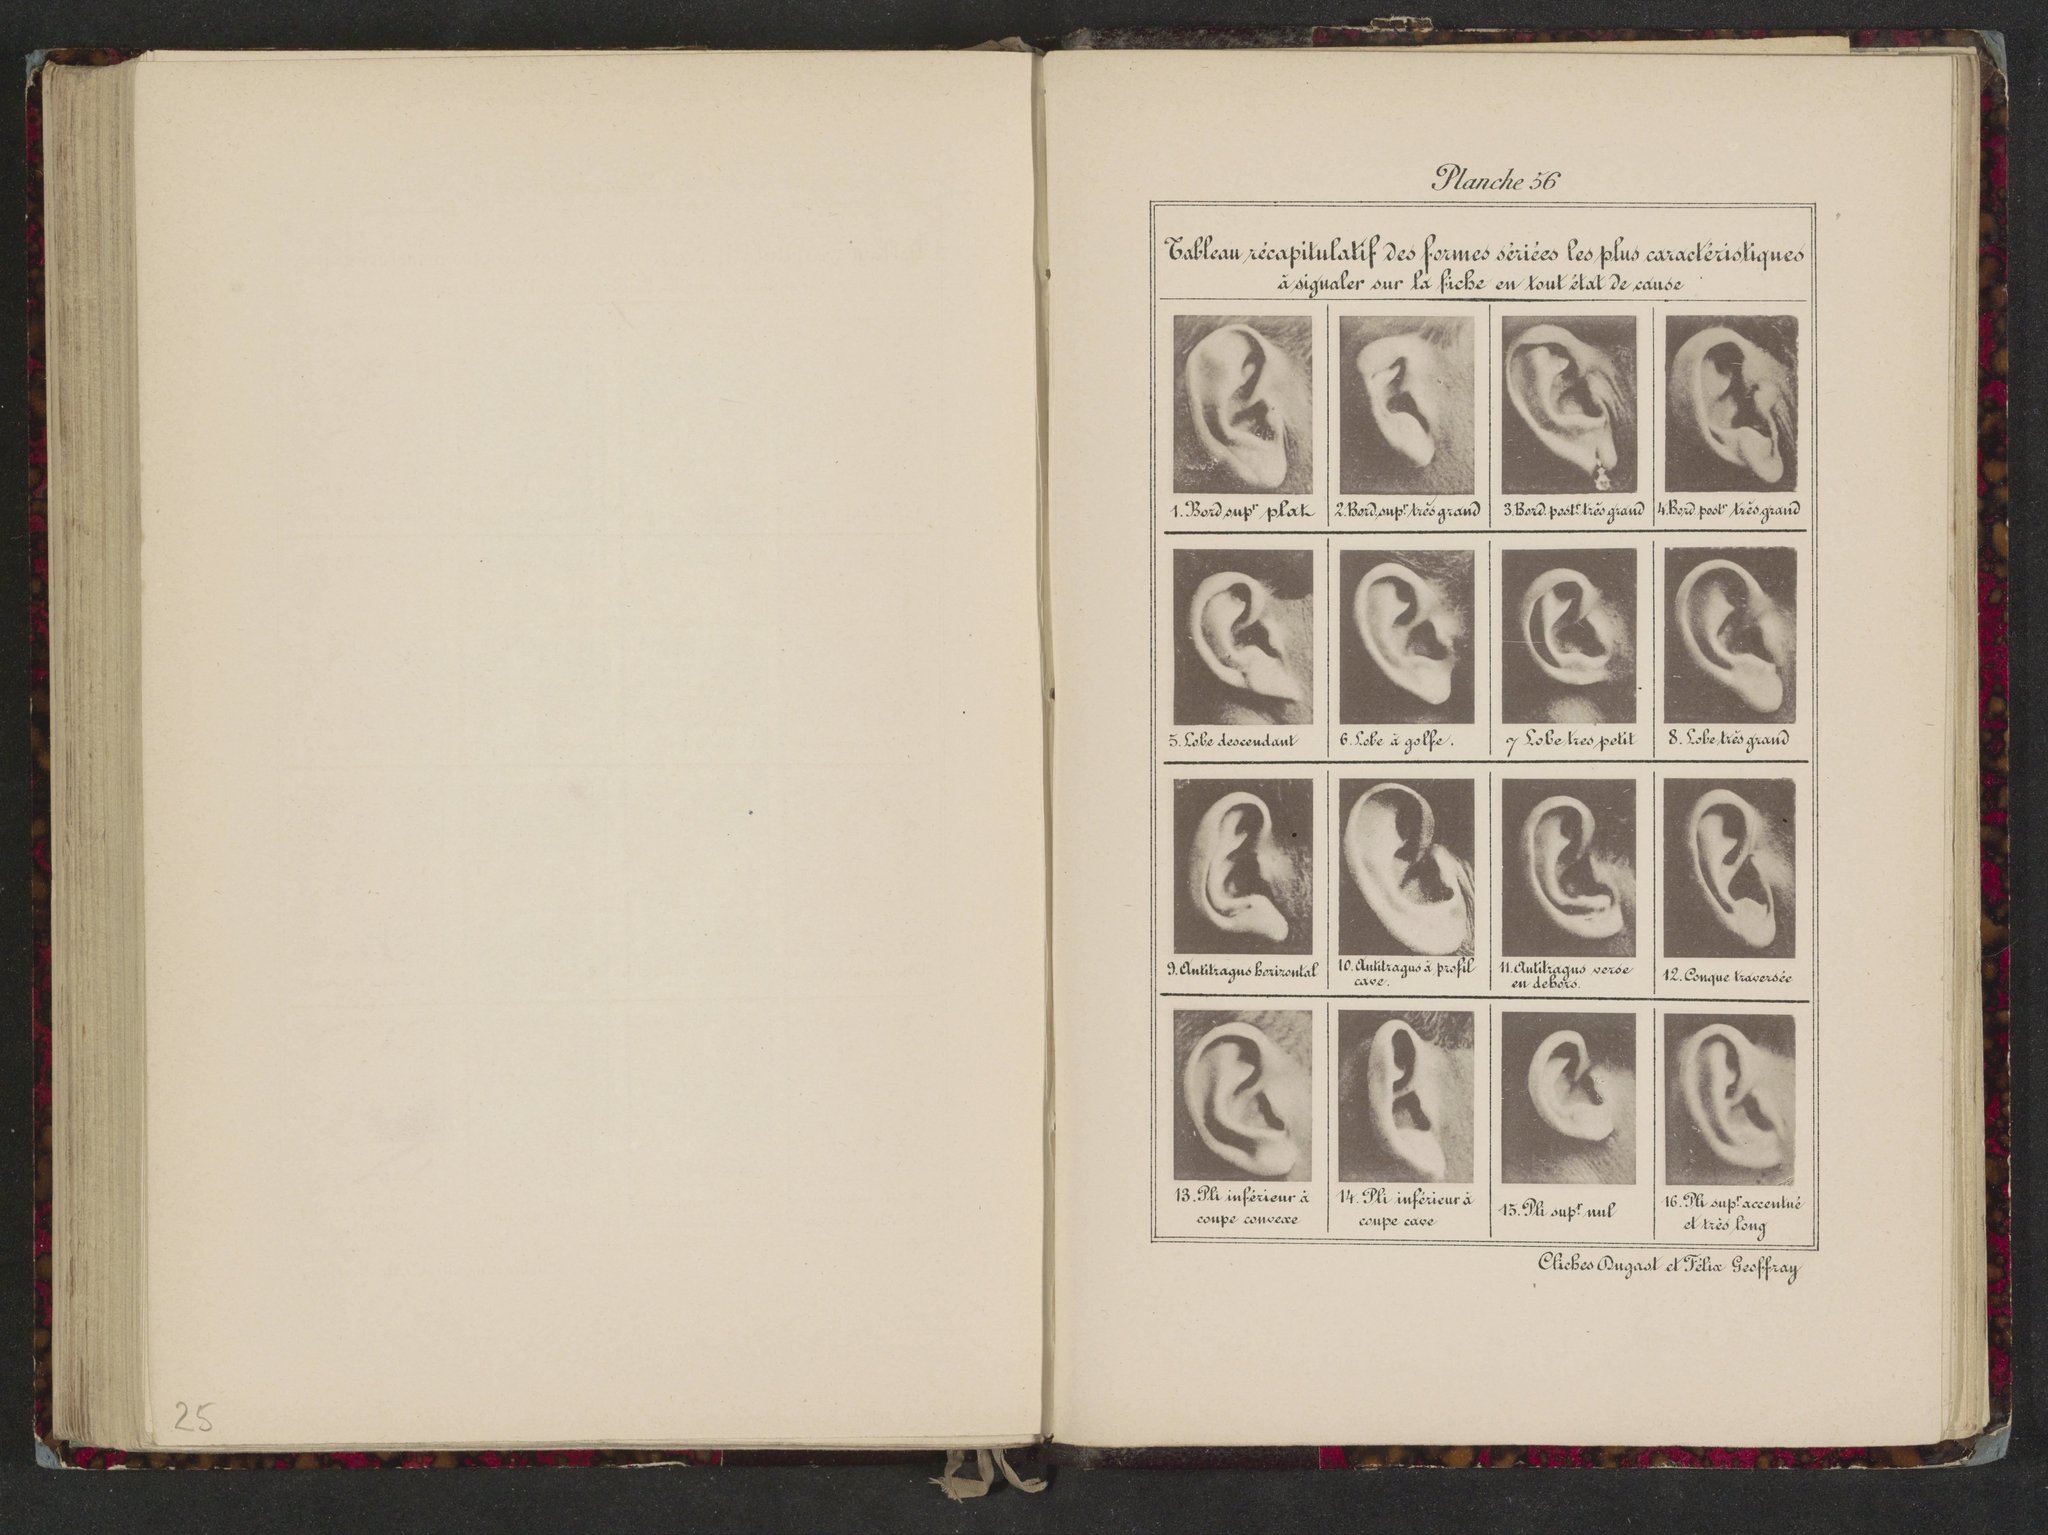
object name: photomechanical print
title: Zestien afbeeldingen van oren, gerangschikt op vorm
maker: Anonymous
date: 1880-1893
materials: paper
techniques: photograph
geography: france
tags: ears, france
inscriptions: inscription: ‘Bord supr plat. (...) Pli supr. accentué et très long’, number: ‘Planche 56.’, number: ‘1. (...) 16.’